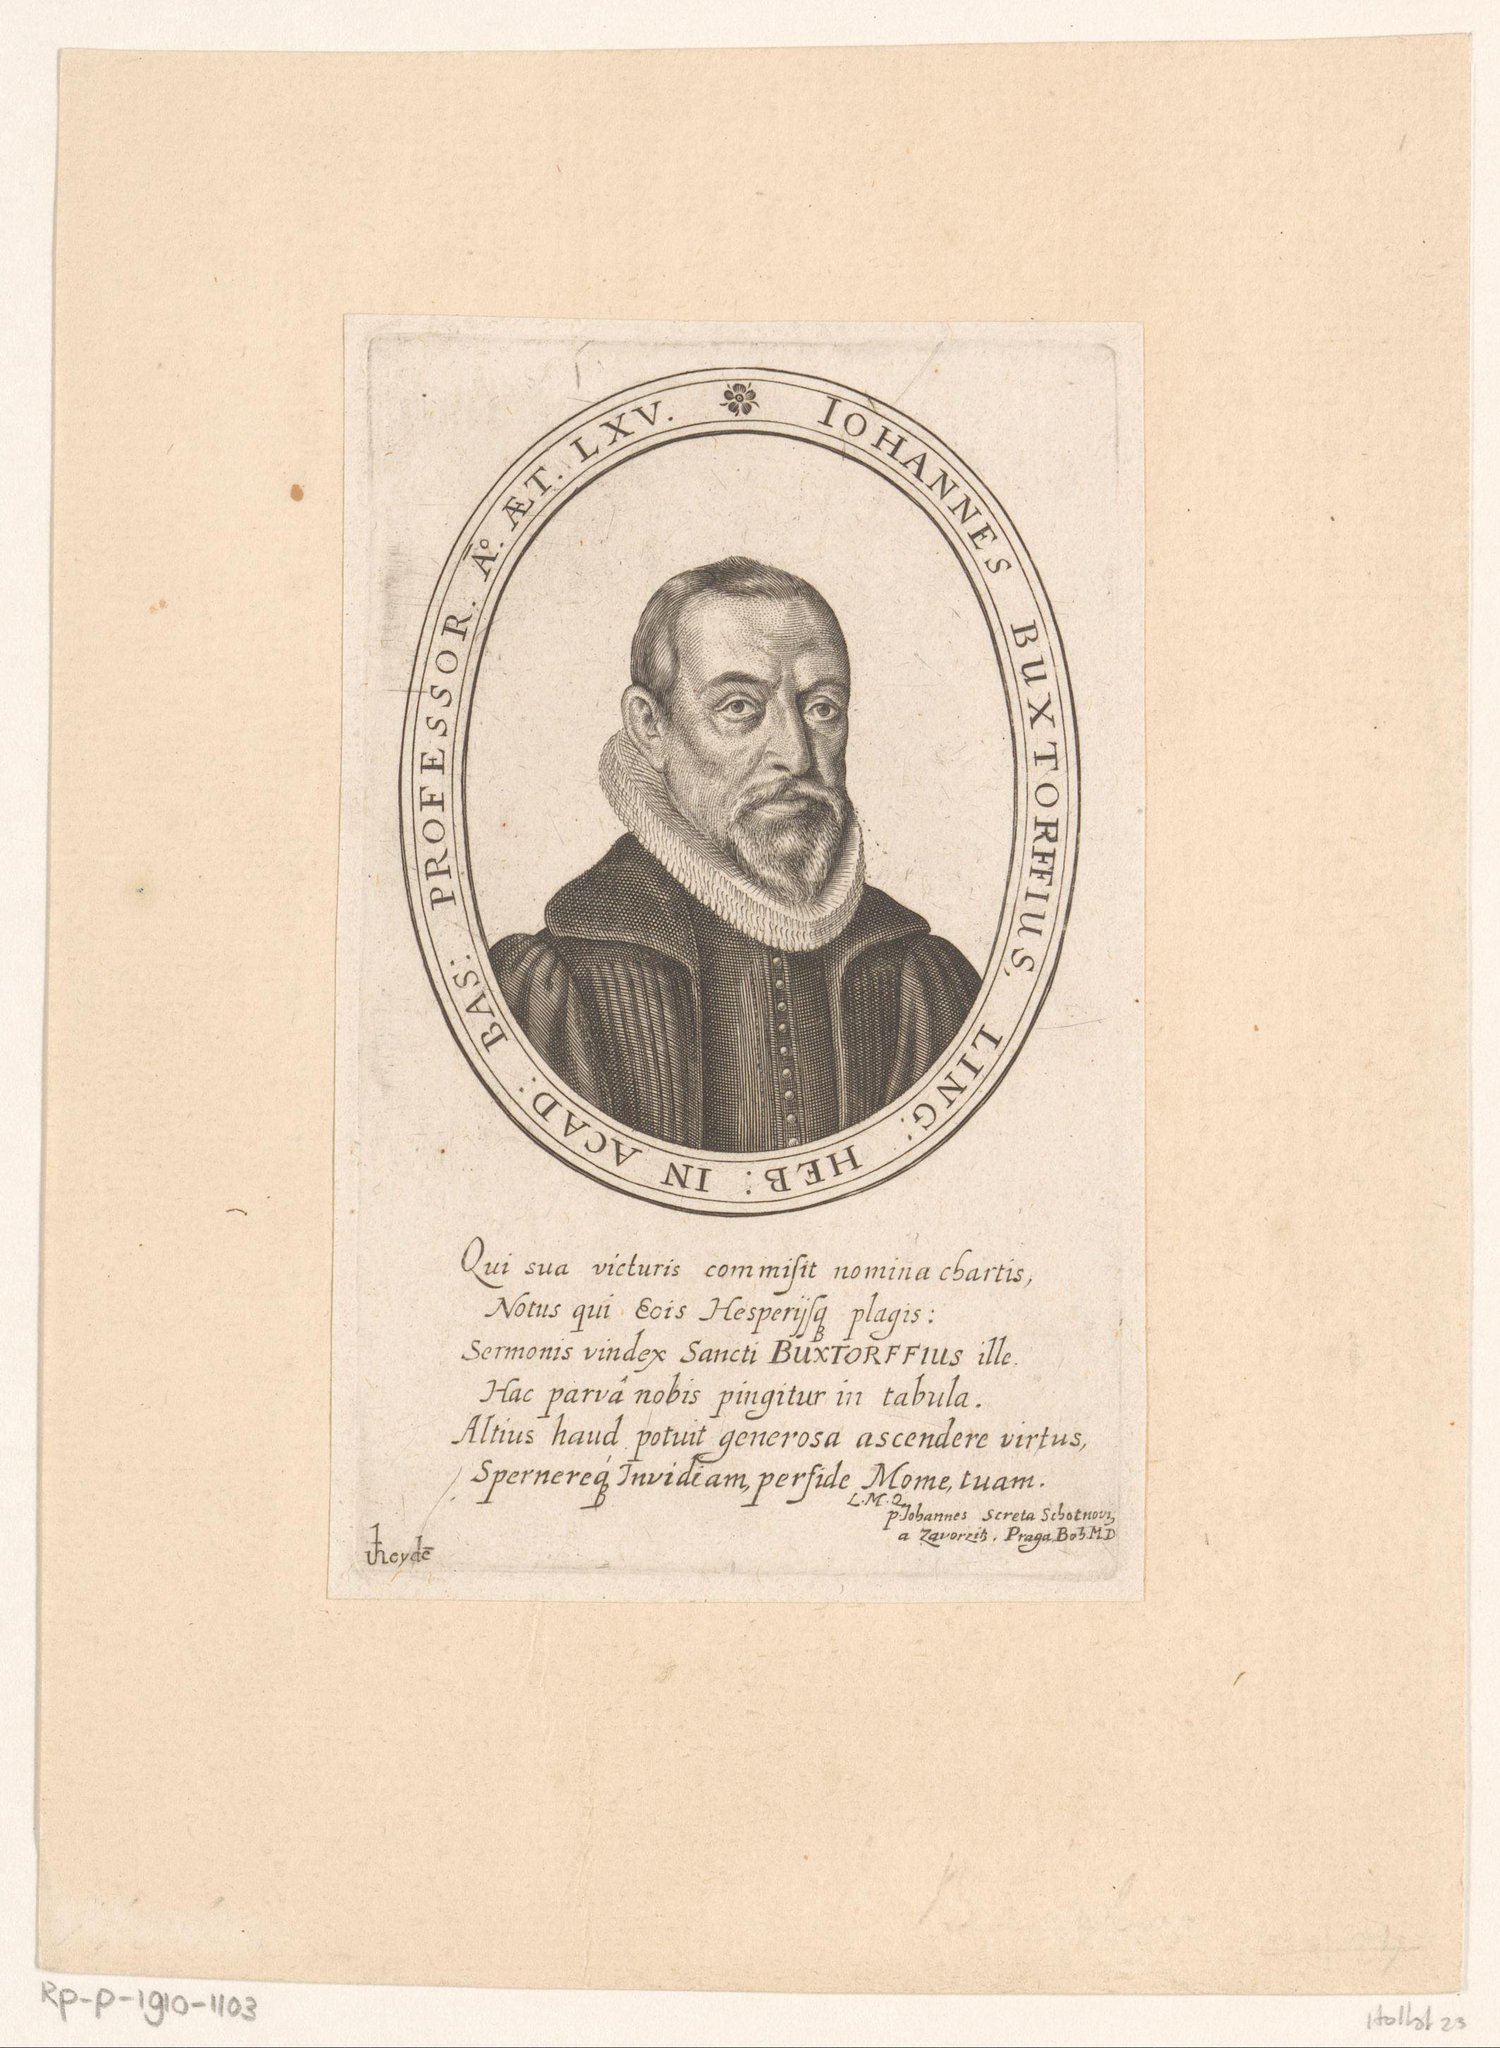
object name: print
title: Portret van Johann Buxtorf op 65-jarige leeftijd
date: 1529-1645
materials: paper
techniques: engraving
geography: prague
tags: westphalia, theologian, historical persons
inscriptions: collector's mark: Lugt 2228